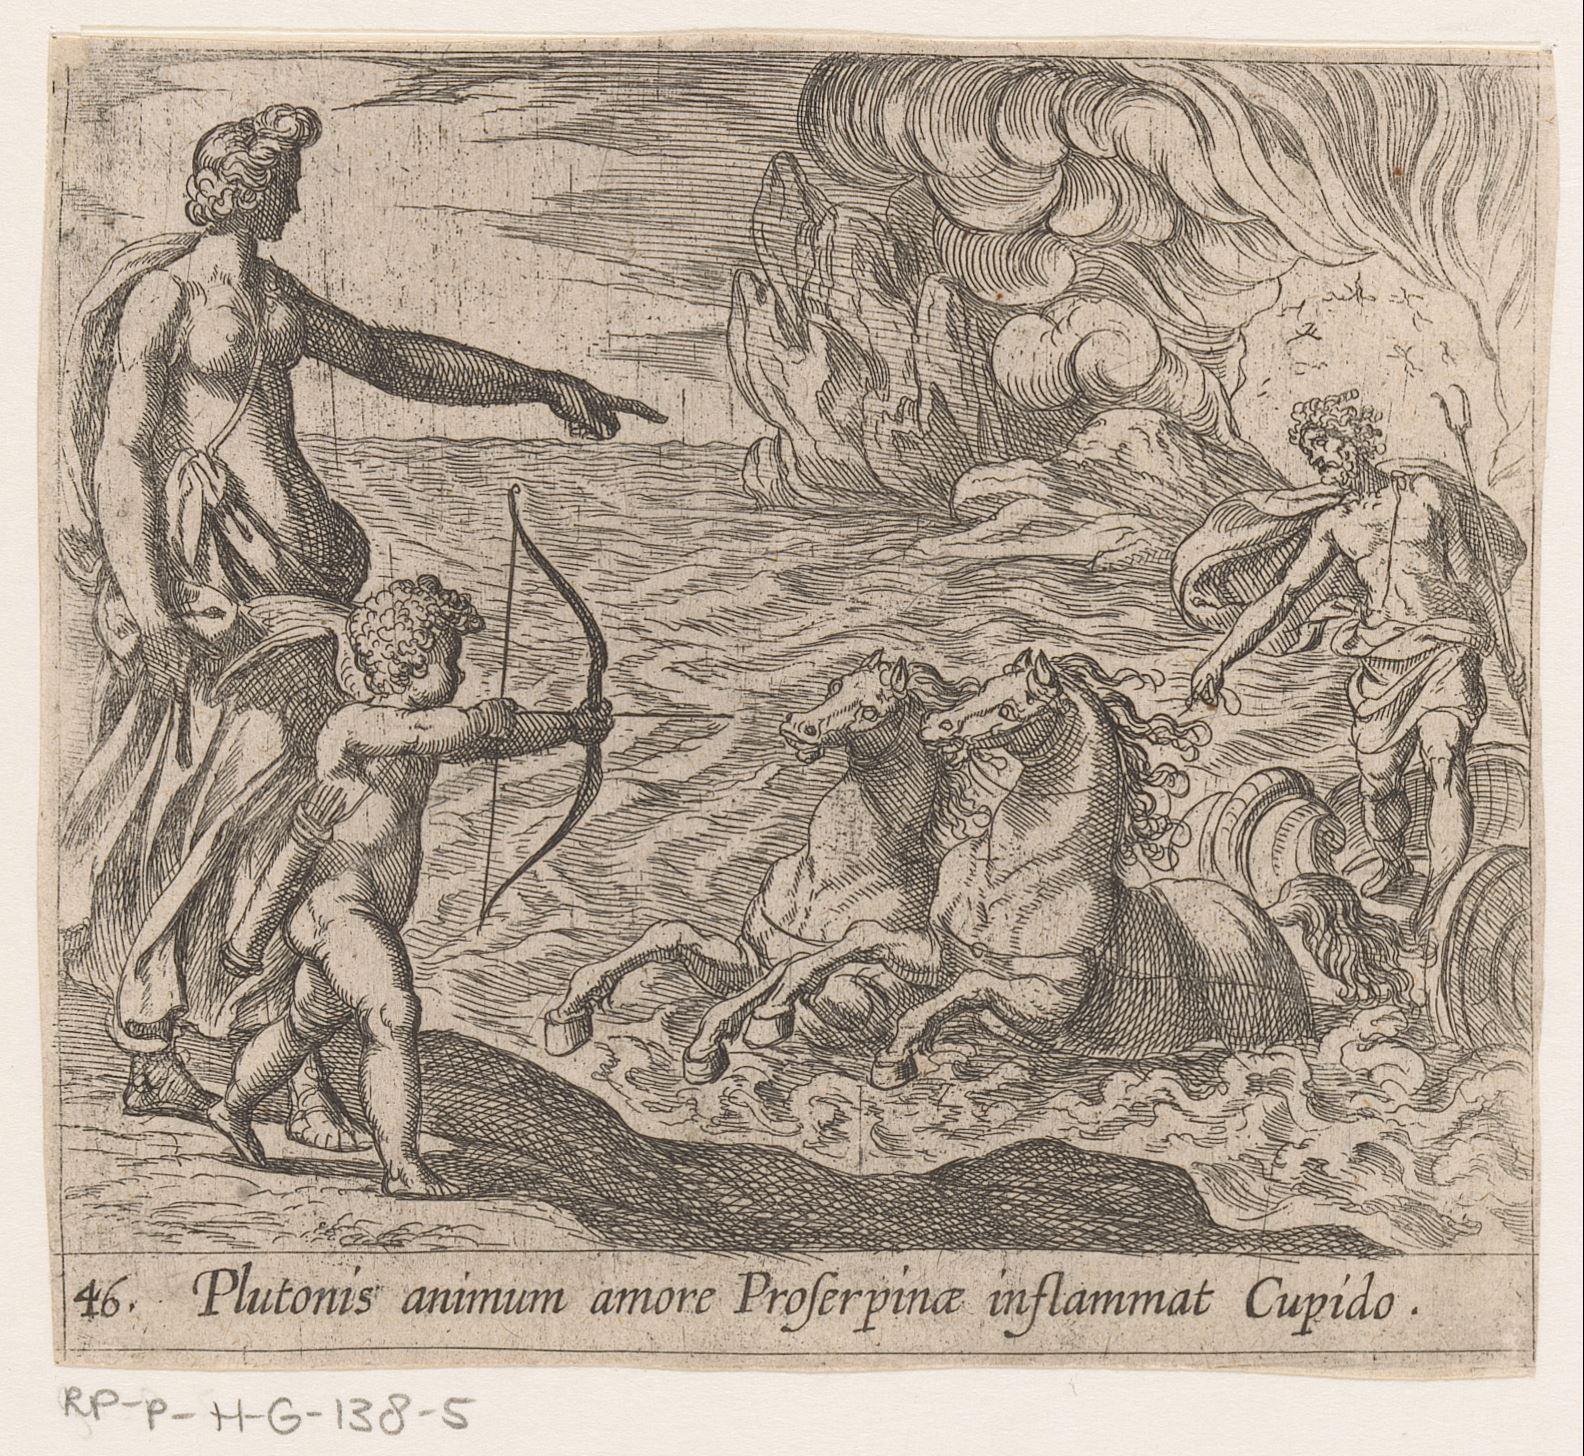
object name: print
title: Plutonis animum amore Proserpinae inflammat Cupido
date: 1606-1638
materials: paper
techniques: etching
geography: italy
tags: cupid shooting a dart at venus' order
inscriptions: collector's mark: ‘Hinloopen’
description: Amor schiet in opdracht van Venus een pijl naar Pluto, die op zijn wagen de Hades uit komt rijden. Titel in het Latijn in ondermarge.